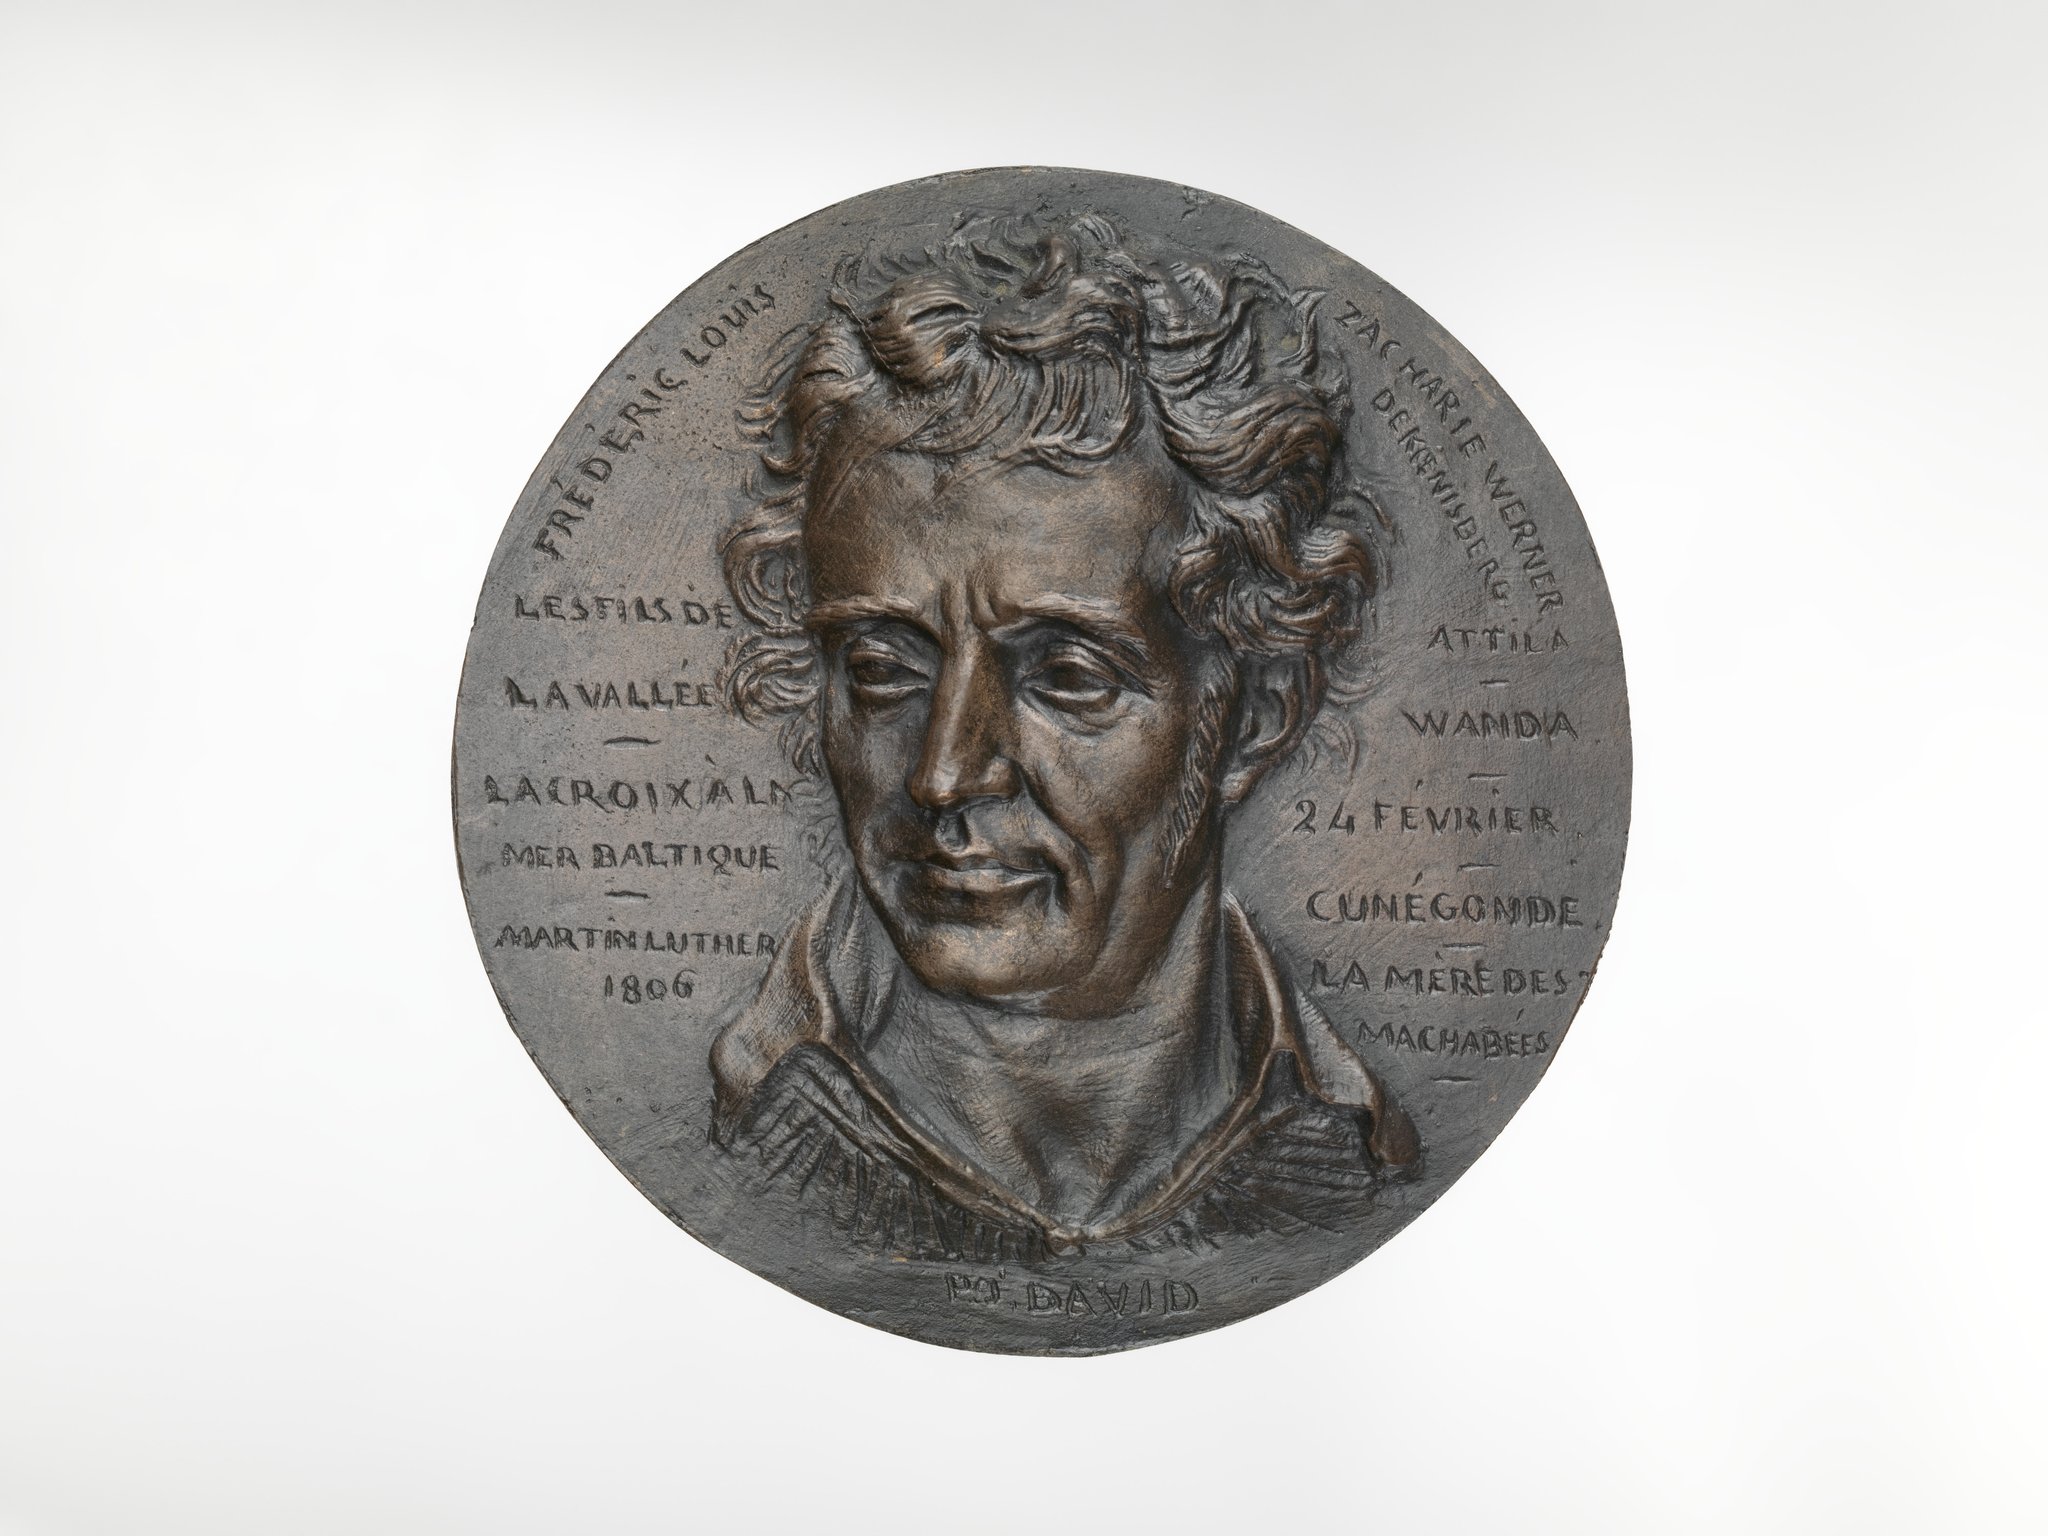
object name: medallion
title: Friedrich Ludwig Zacharias Werner (1768–1823)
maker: pierre jean david d'angers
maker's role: artist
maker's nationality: french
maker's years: 1788-1856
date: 1801-1900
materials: bronze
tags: men,portraits